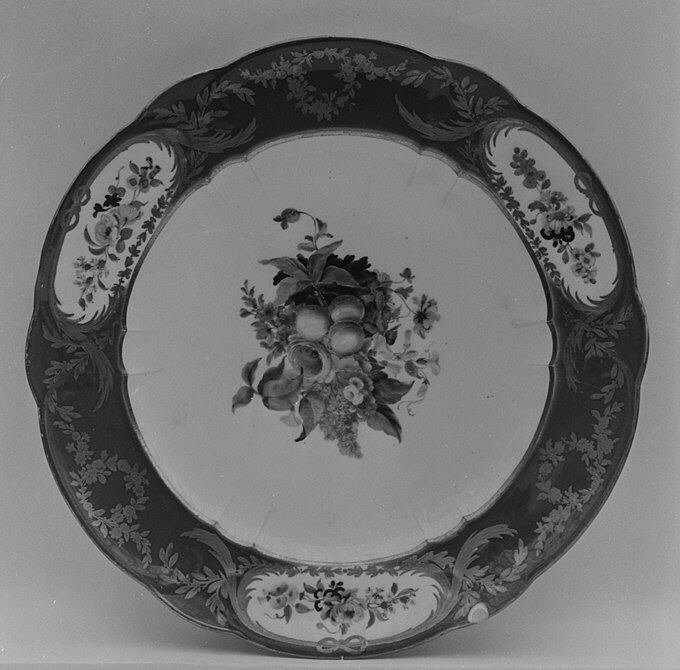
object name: plate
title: Plate (part of a service)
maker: sèvres manufactory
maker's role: manufactory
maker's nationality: french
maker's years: 1740-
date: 1784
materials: soft paste porcelain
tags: fruit,flowers